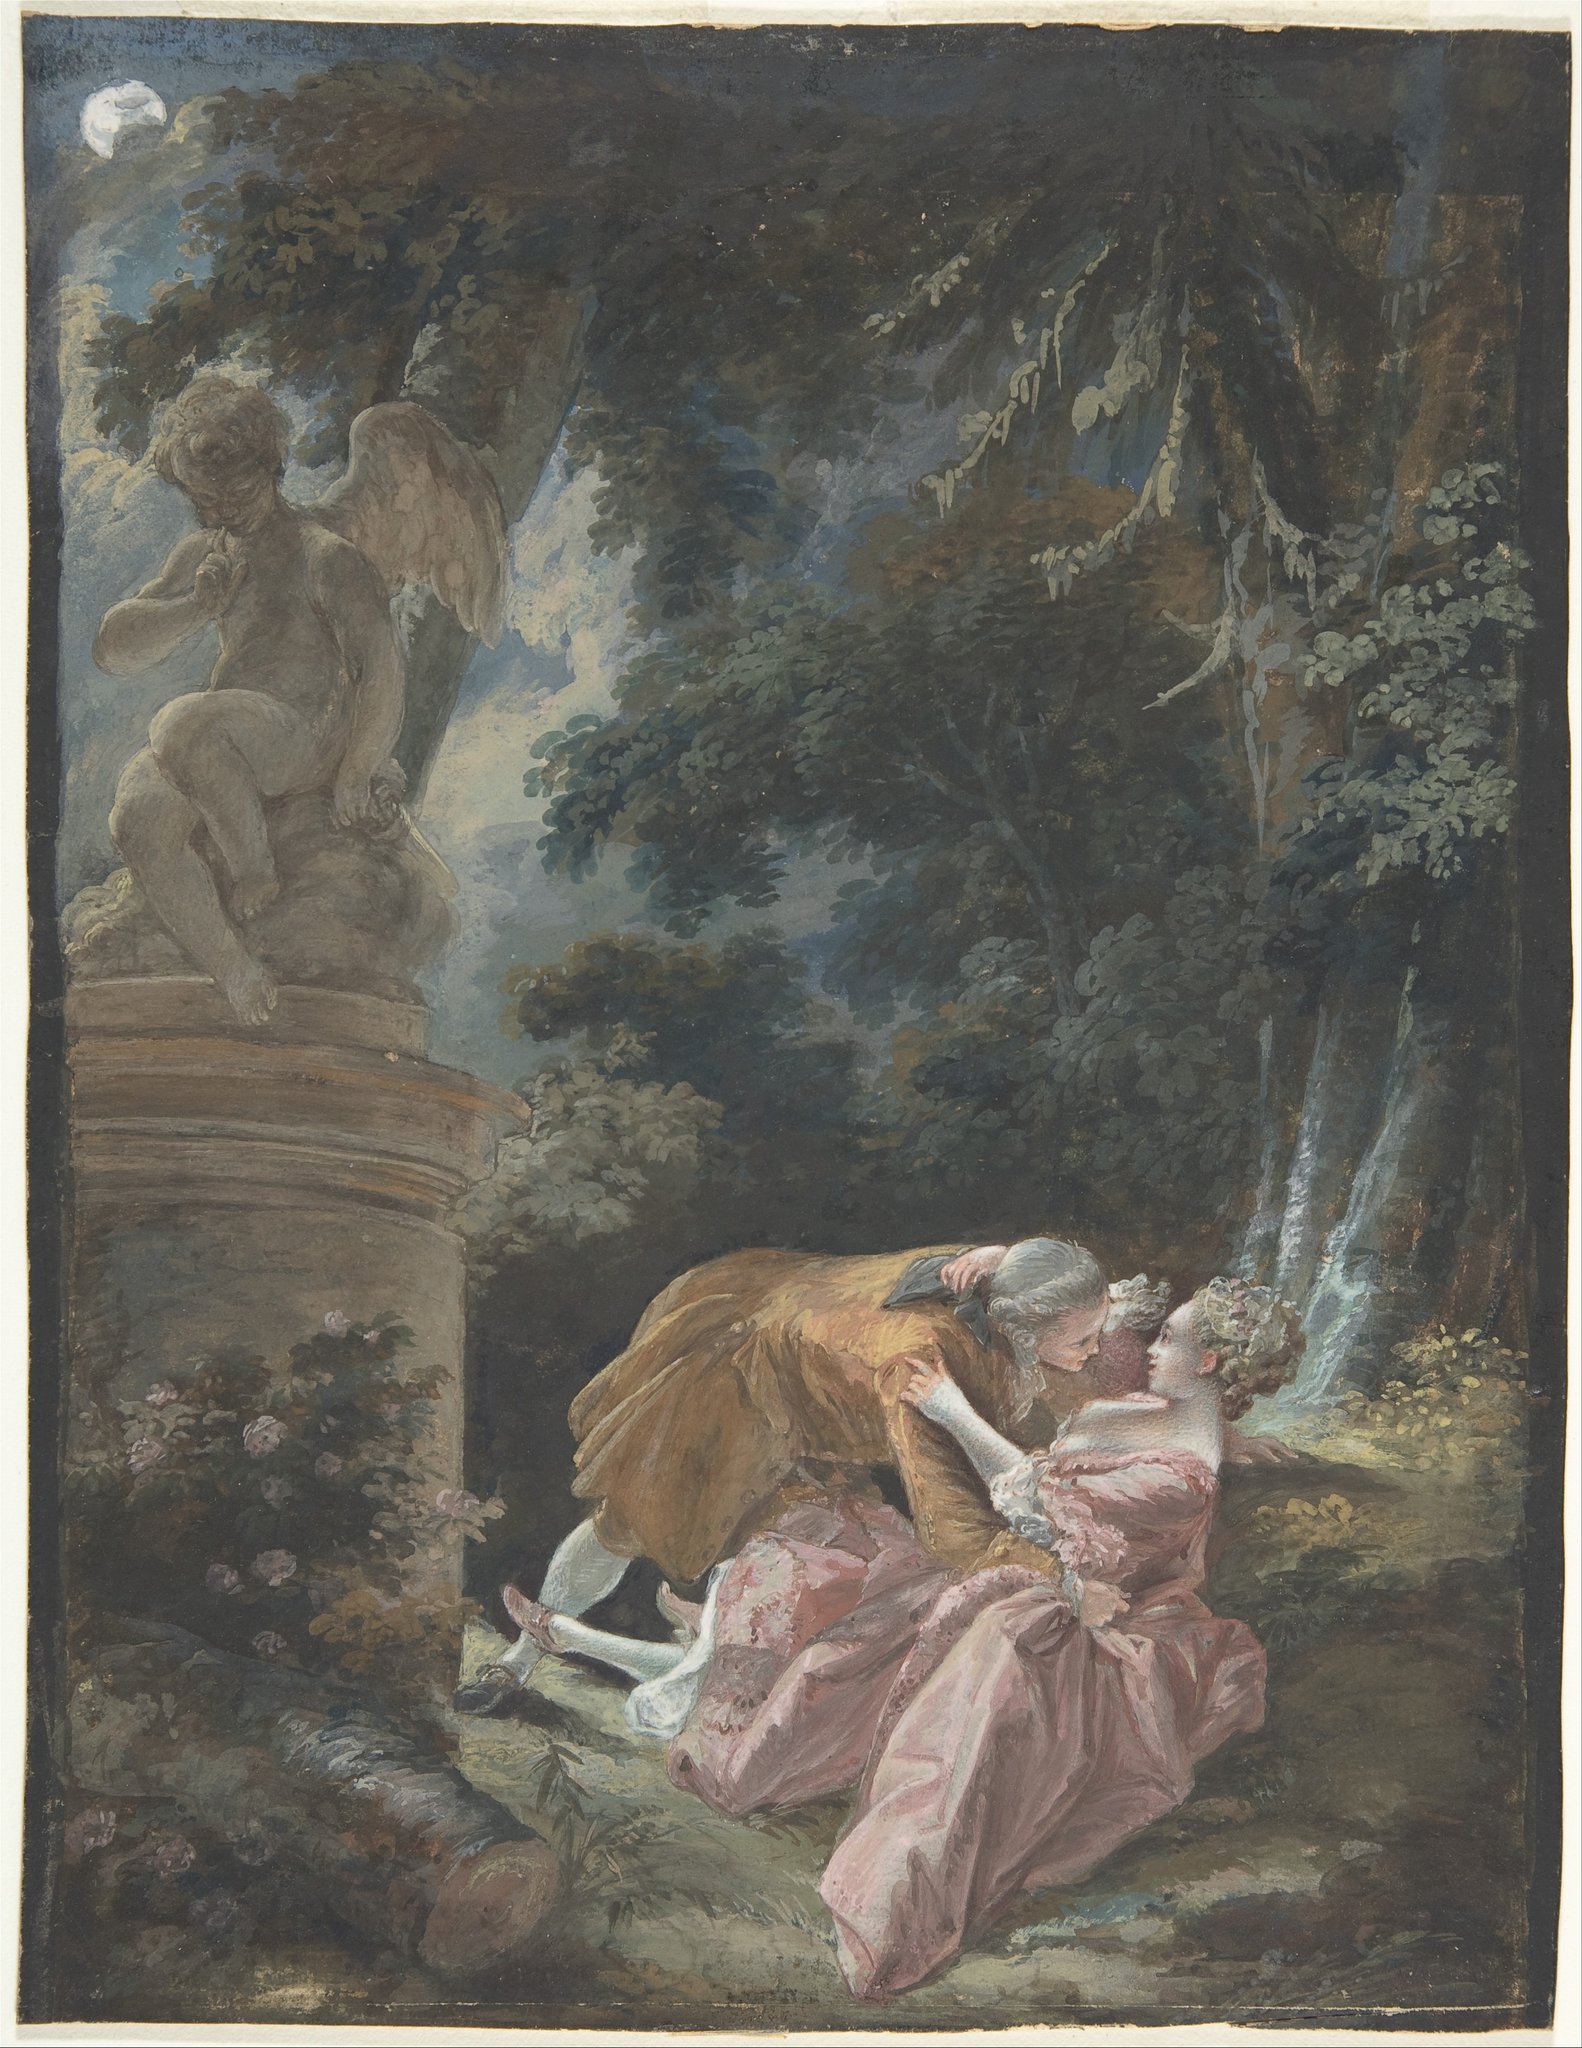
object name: drawing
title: La Nuit (Night)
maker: pierre antoine baudouin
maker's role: artist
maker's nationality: french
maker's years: 1723-1769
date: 1723-1769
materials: board, gouache, paper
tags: couples,men,lovers,women,putti,night